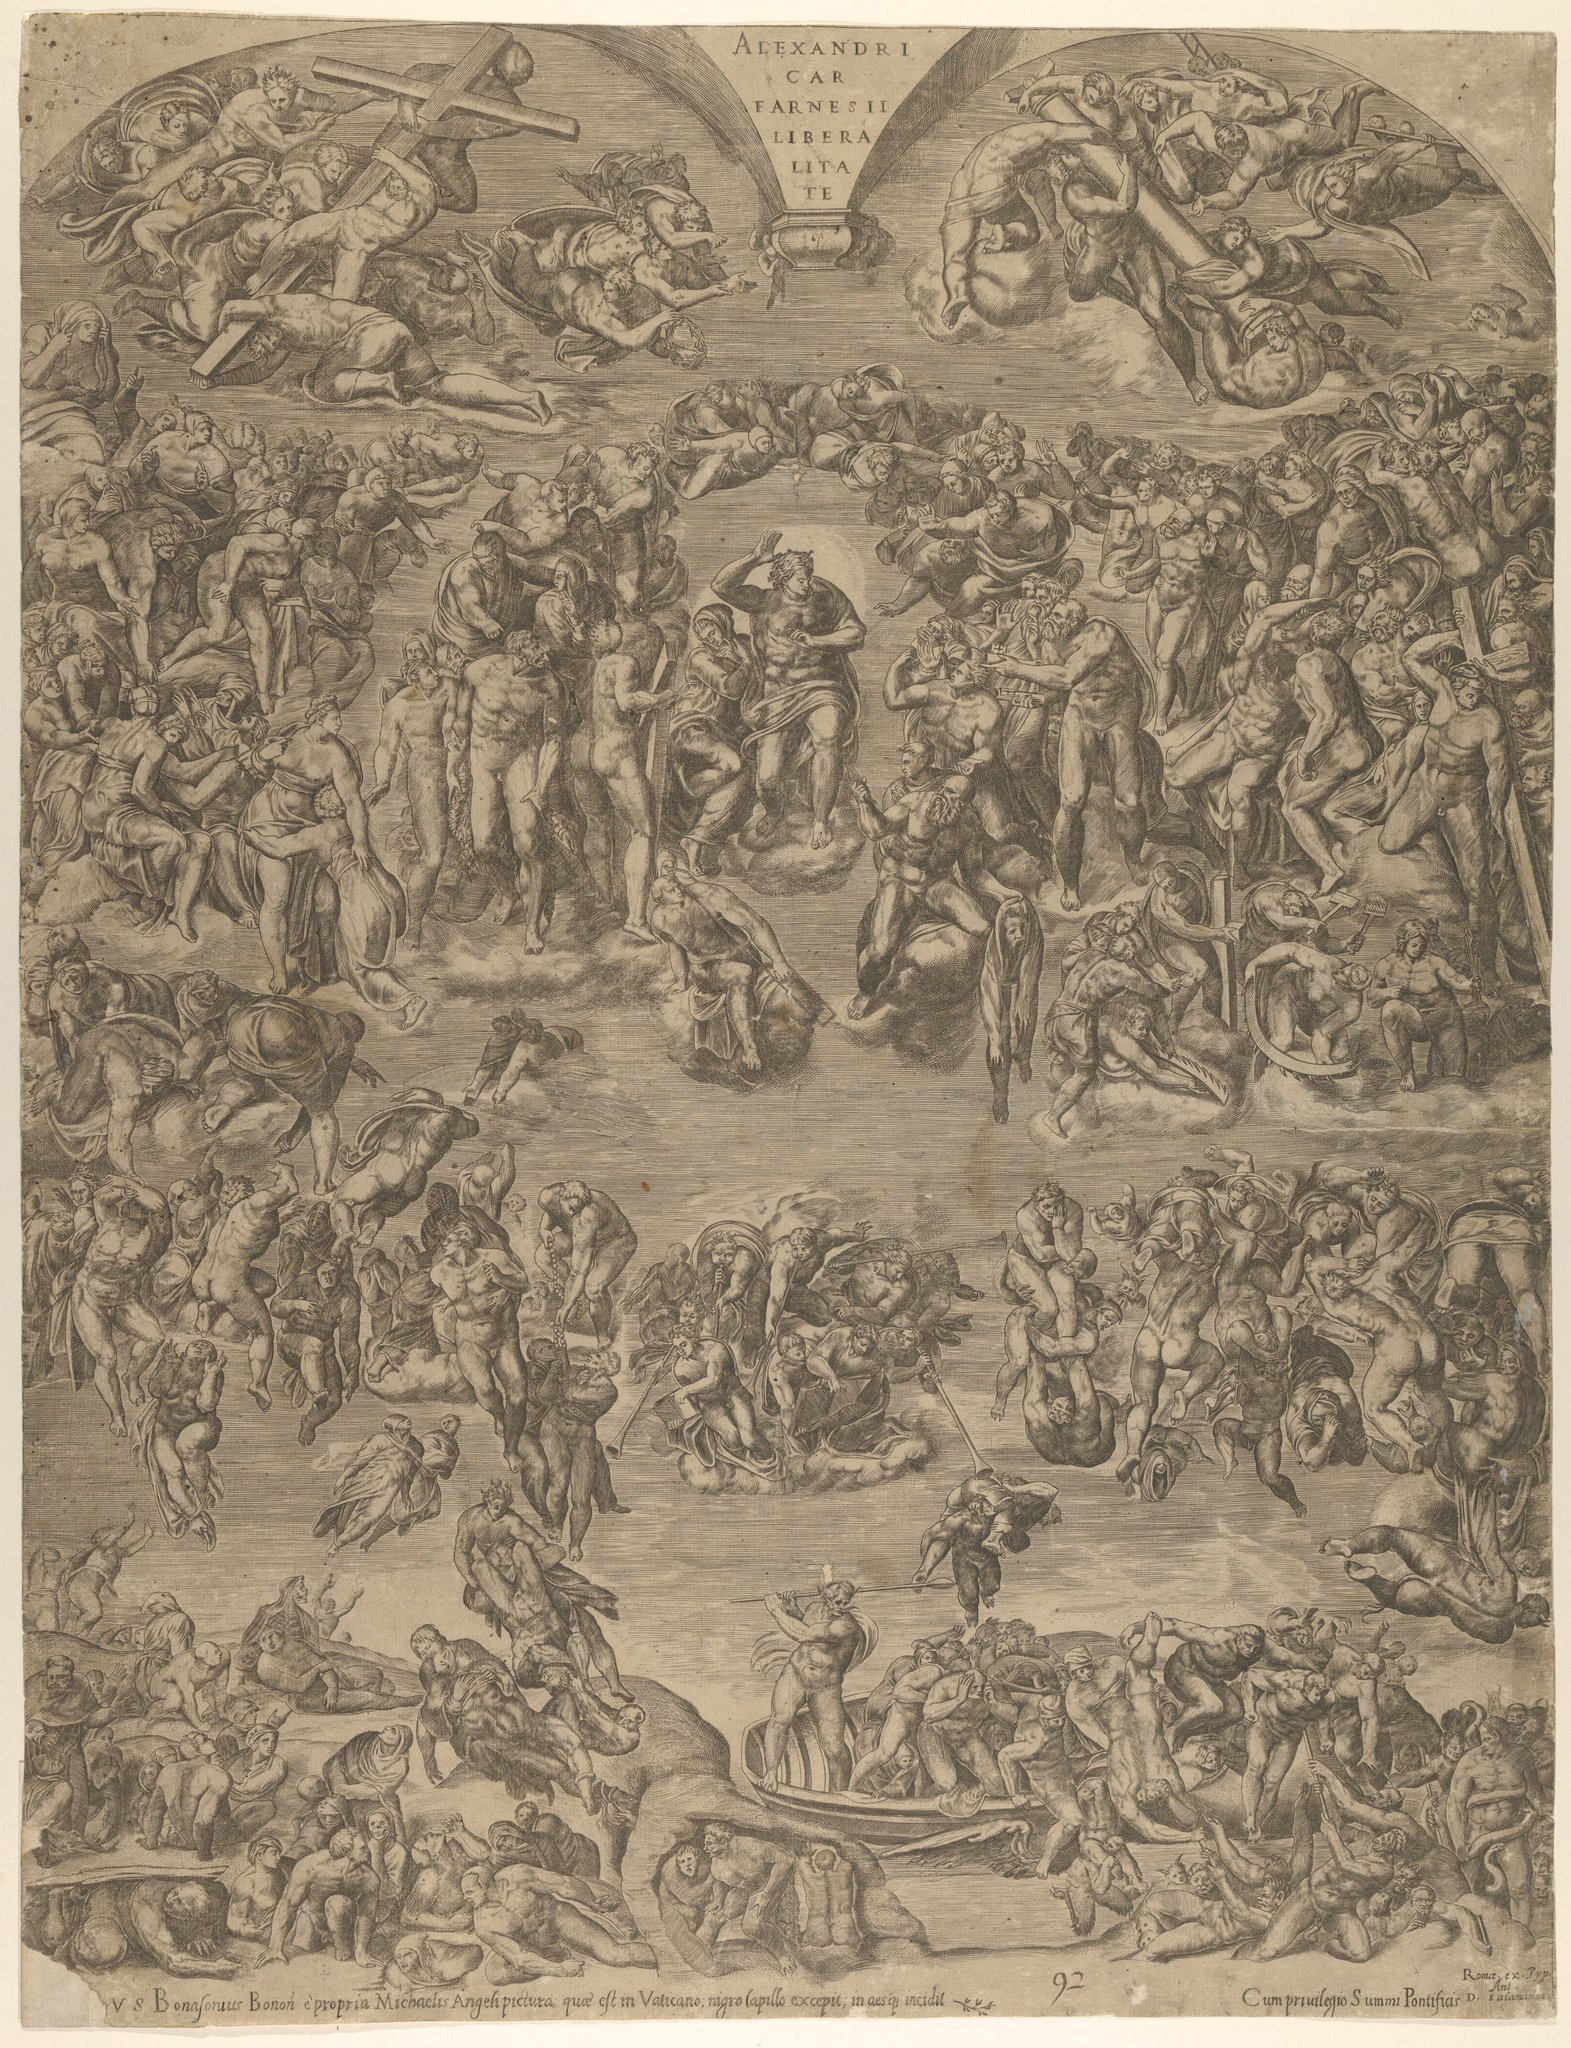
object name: print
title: The Last Judgment from the Sistine Chapel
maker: giulio bonasone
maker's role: artist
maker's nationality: italian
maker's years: 1510-1576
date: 1546-1550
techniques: engraving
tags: angels,jesus,last judgement